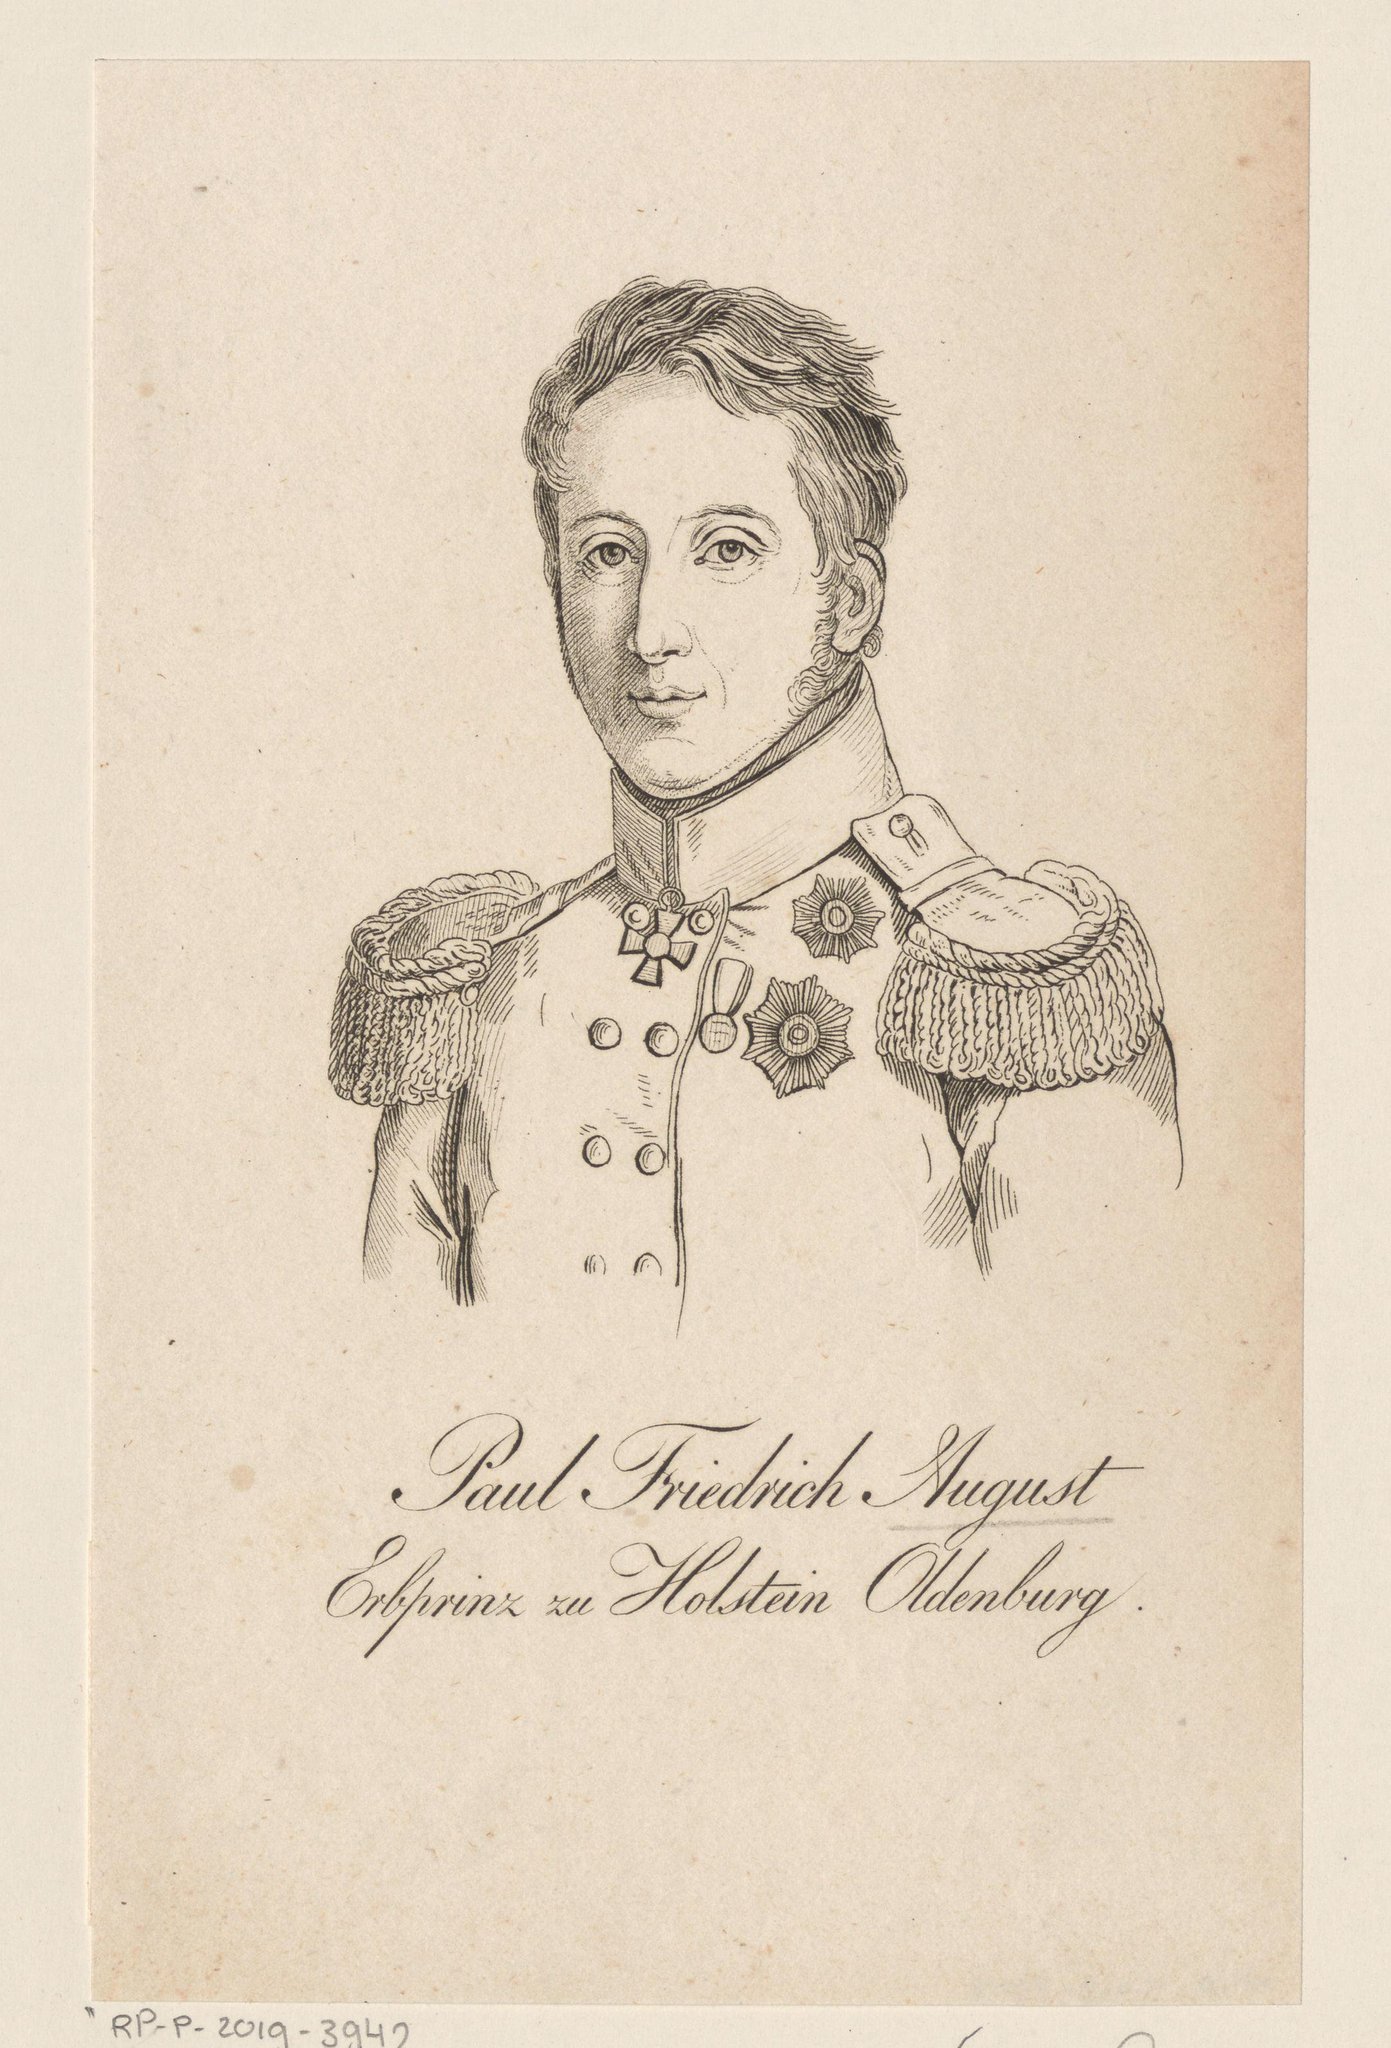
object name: print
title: Portret van August van Oldenburg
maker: Anonymous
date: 1800-1849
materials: paper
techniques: etching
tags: august van oldenburg, historical persons